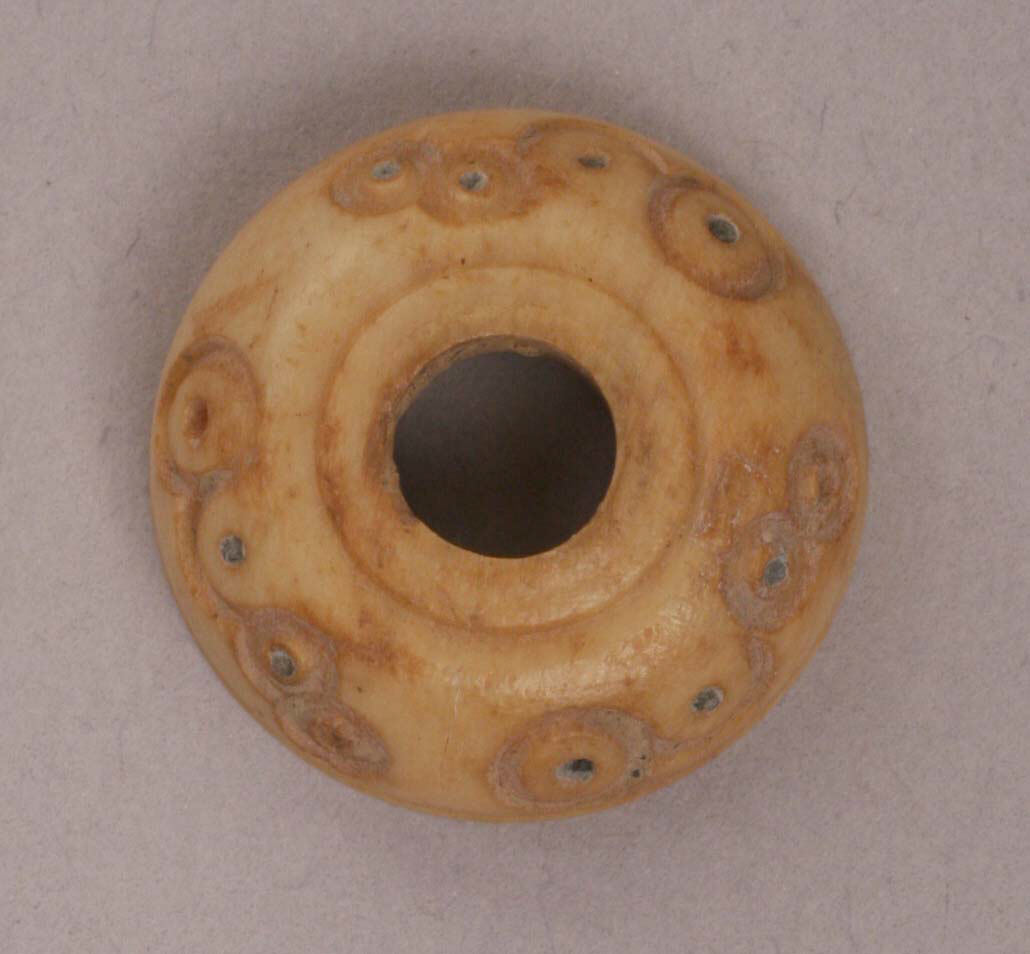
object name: button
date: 801-1000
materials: bone, paint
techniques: incising, inlay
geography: iran